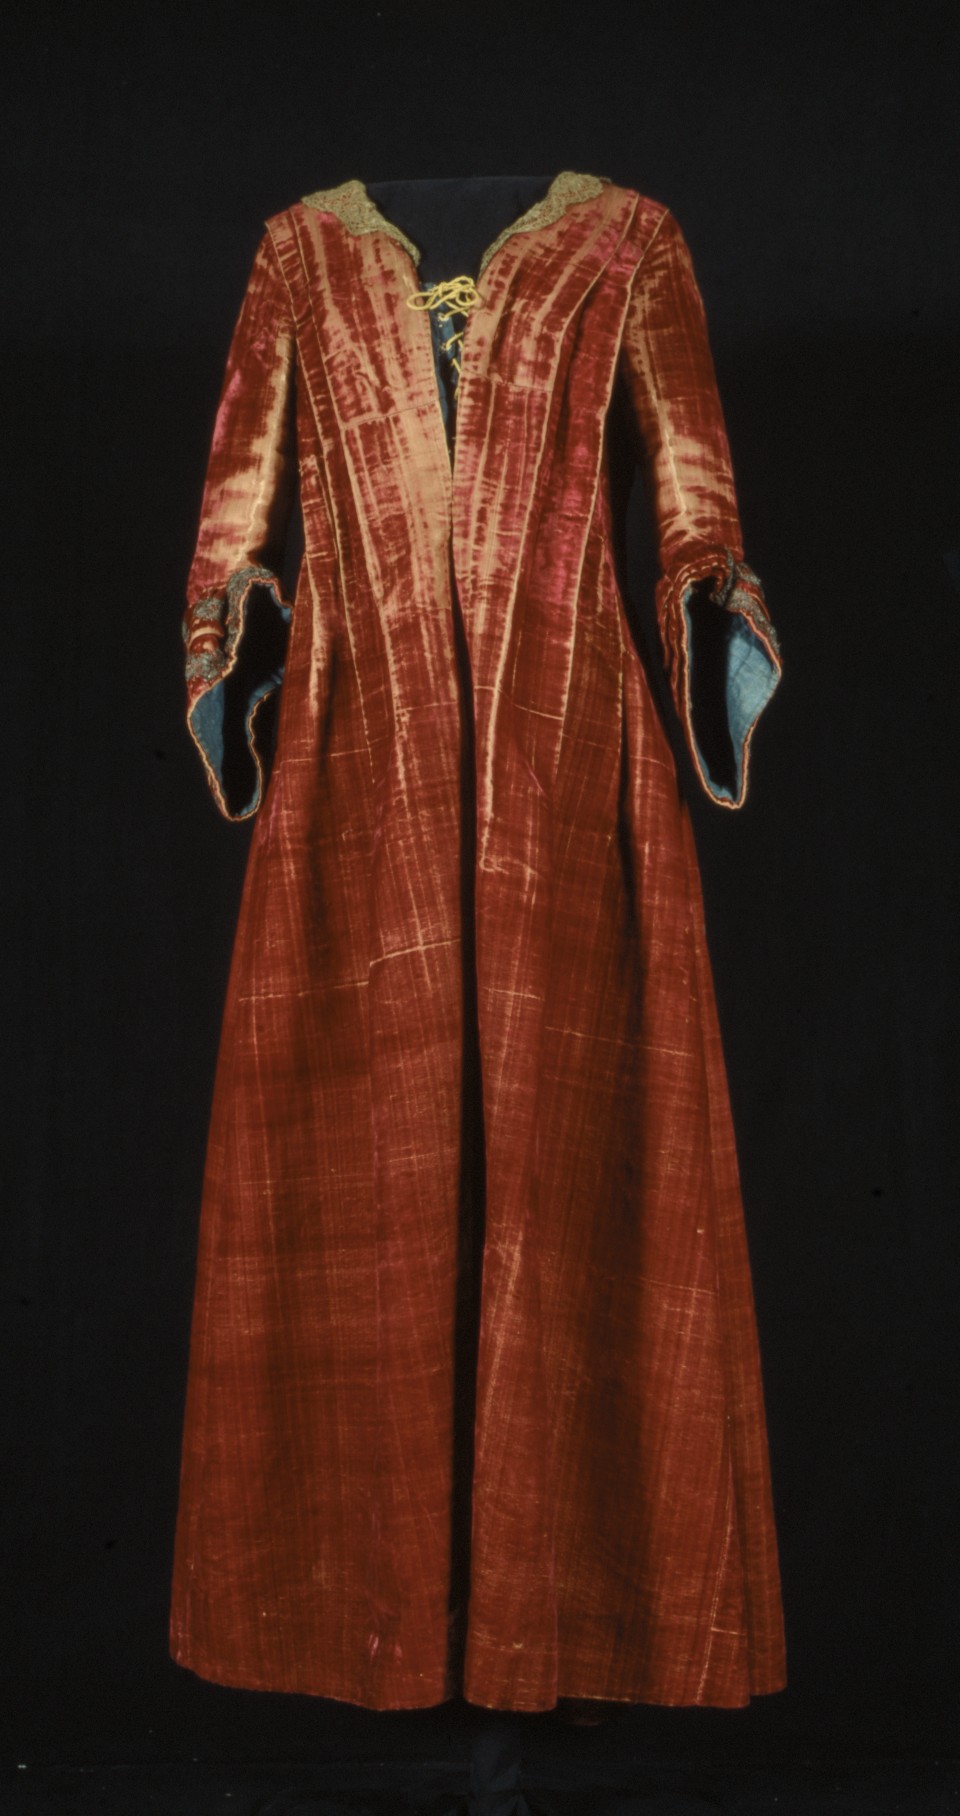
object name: robe à la française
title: Woman's Gown (Robe á la française)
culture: french or italian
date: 1751-1800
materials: linen, metal, silk